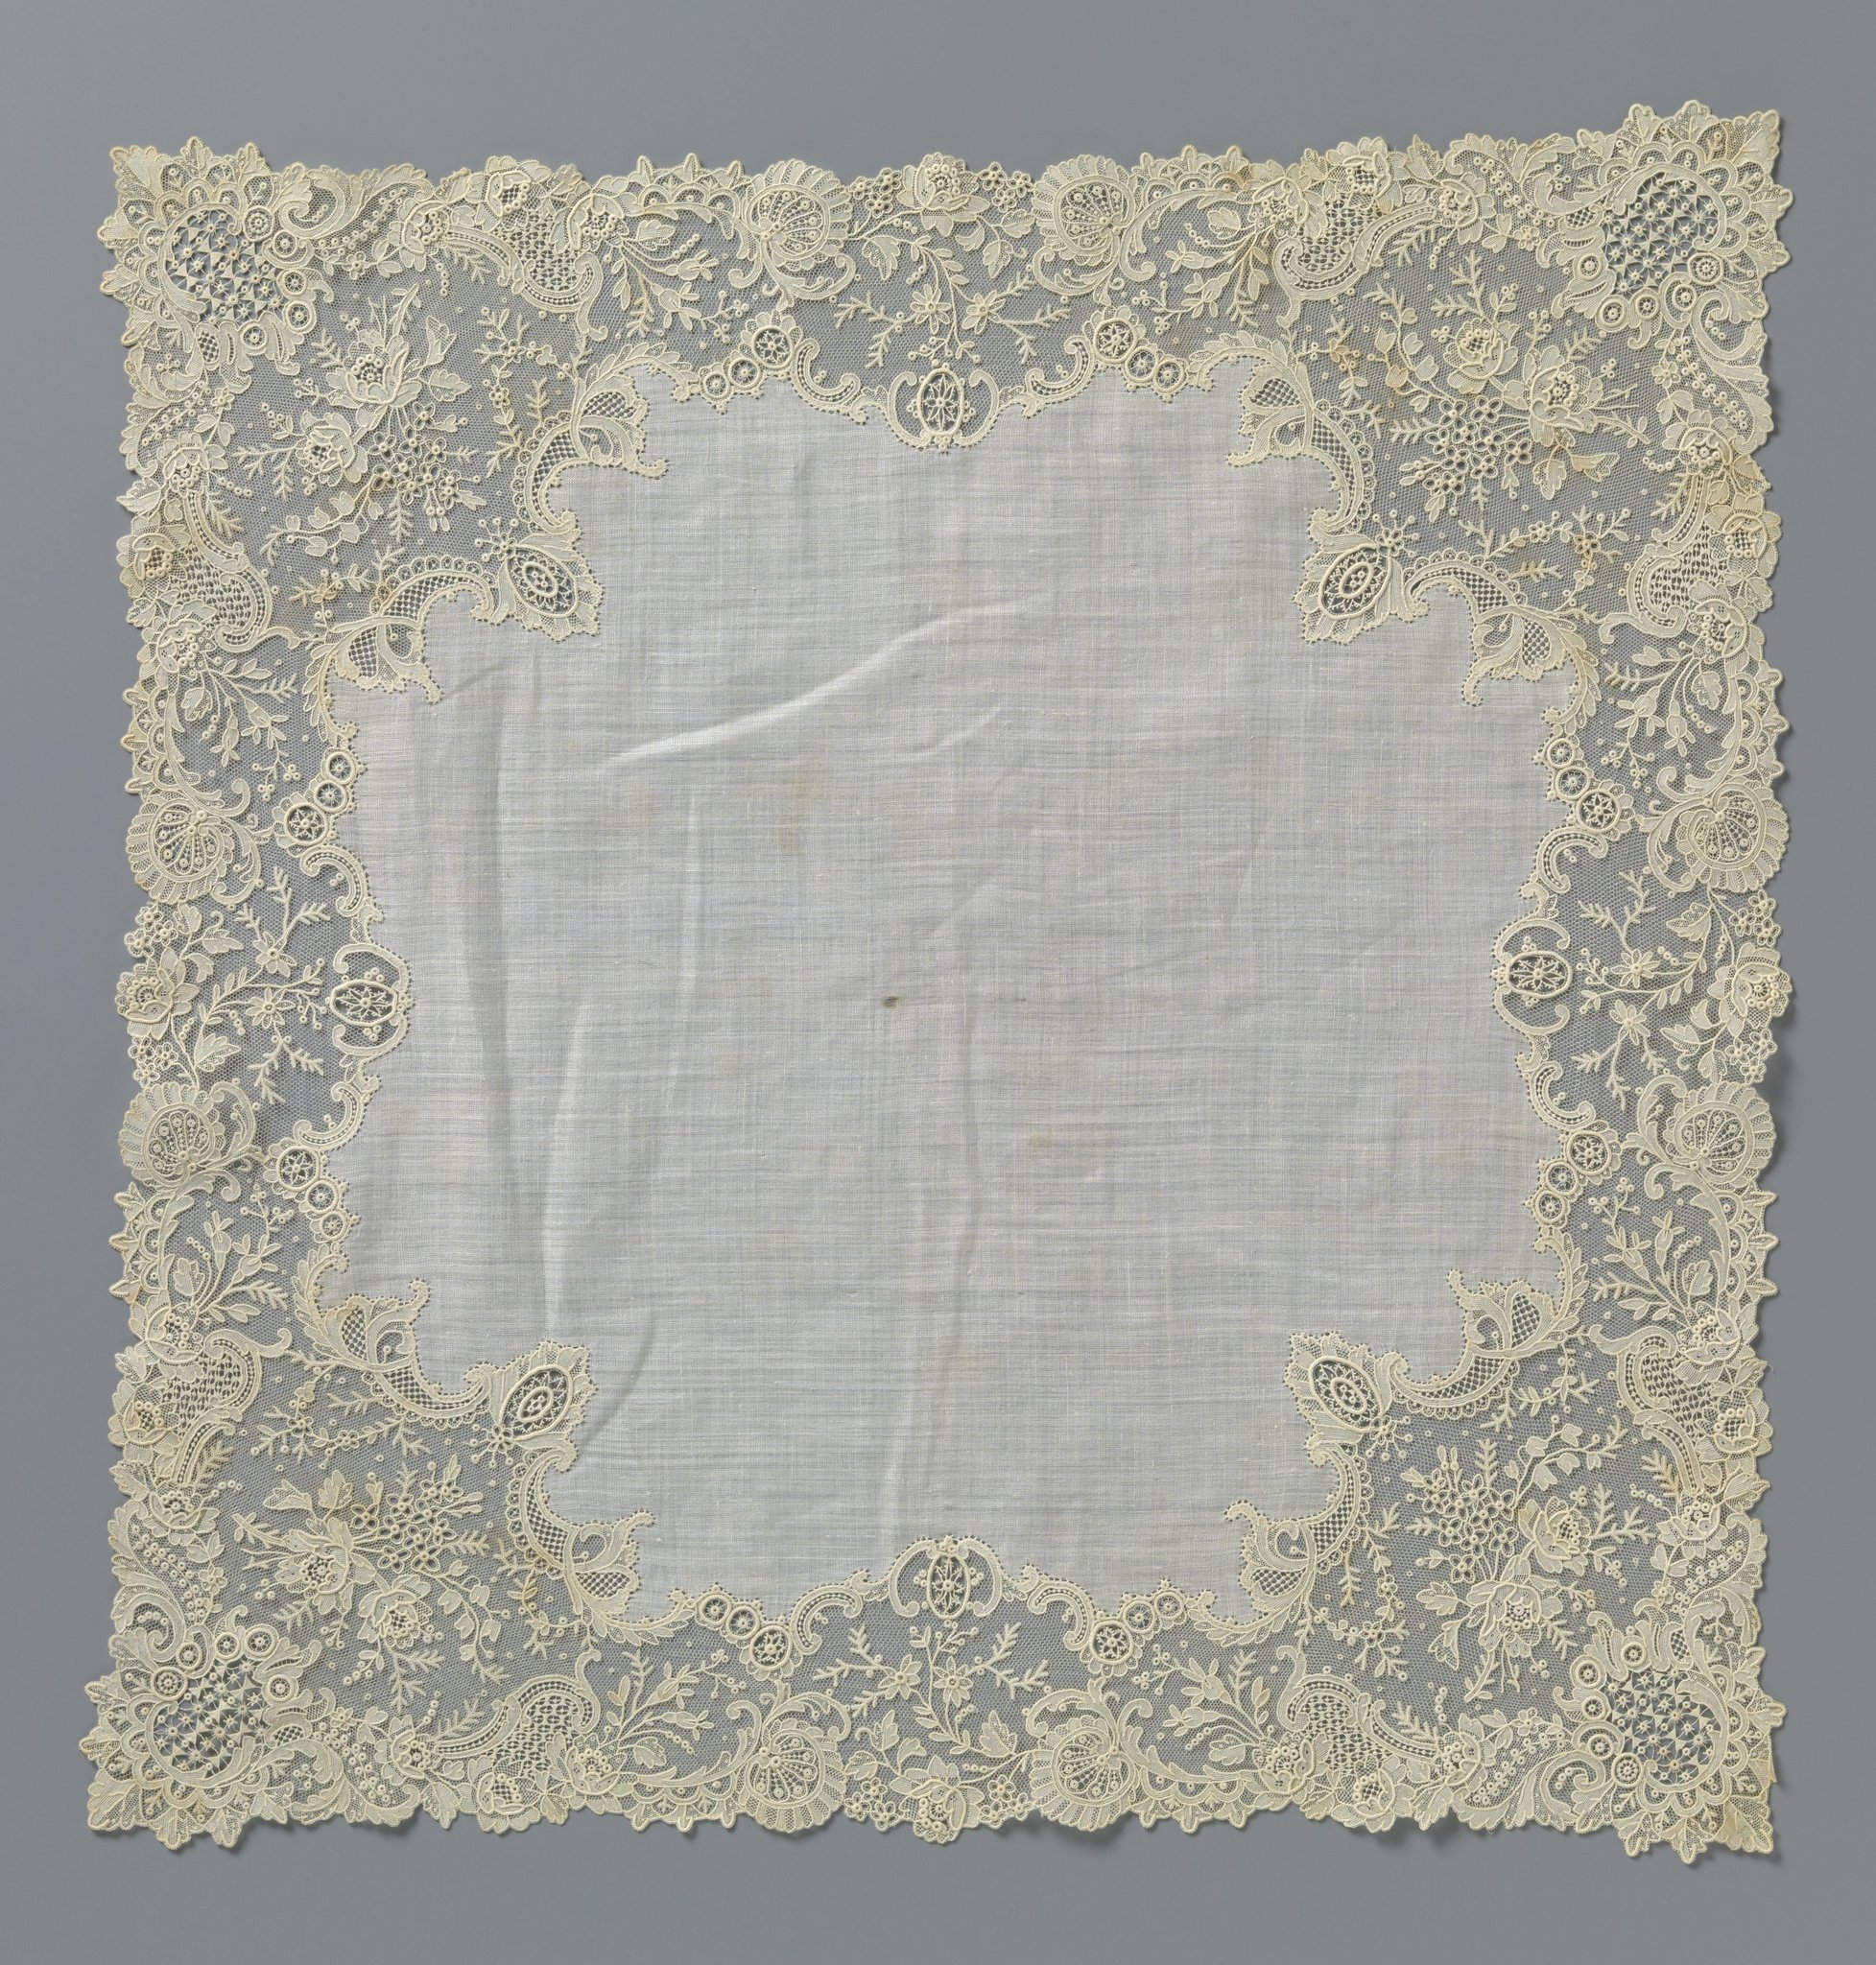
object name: handkerchief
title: Zakdoek met een rand van naaldkant met hoekrocailles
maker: Anonymous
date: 1840-1860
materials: linen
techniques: lace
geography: brussels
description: Zakdoek met een rand van naturelkleurige naaldkant: Brusselse gaaskant. Om een groot, gelobd, batisten middenstuk loopt een kanten rand met hoekrocailles, gevuld met open rasterwerk. Binnen- en buitencontouren zijn samengesteld uit fijne c-voluten, ovaaltjes, rondjes en acanthusbladeren. Op het mazennet staan verscheidenen fijne toefjes van rozen, seringen, rozeknopjes en vergeetmijnieten. Een meer gesloten rand vertoont rozen, geschubde randen, waaierpalmetten met godronrand en rocailles met rastervulling.